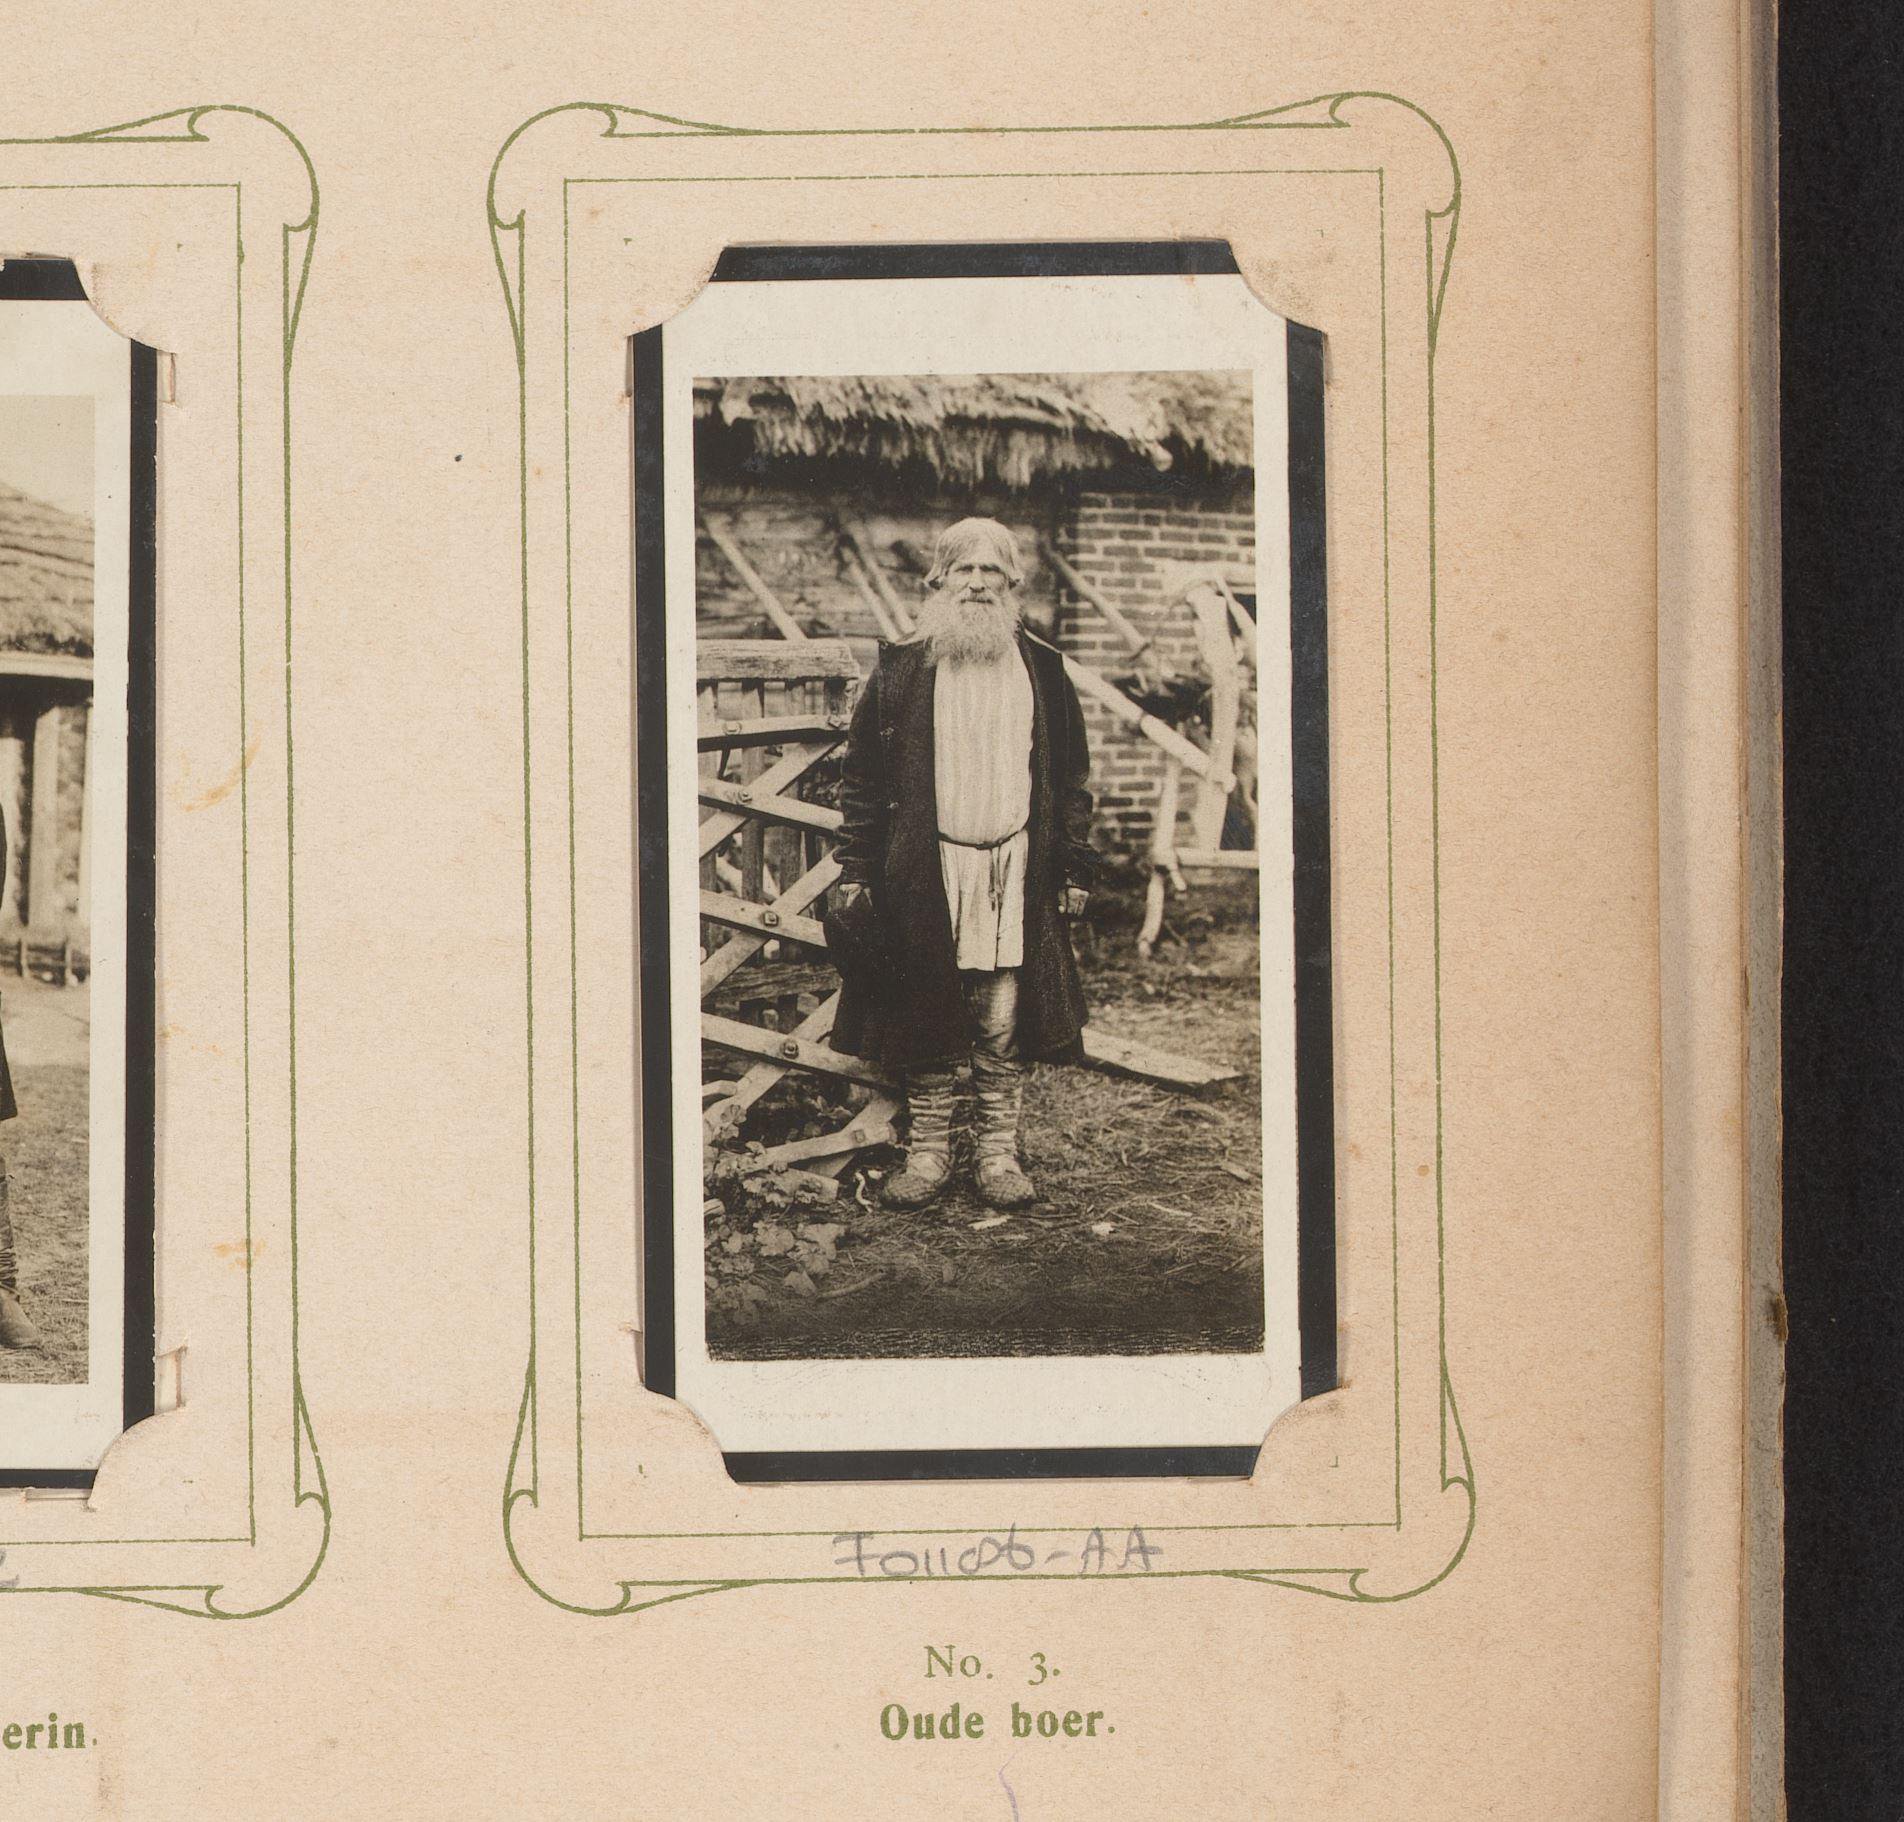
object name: album leaf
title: Portret van een oude Russische boer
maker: Anonymous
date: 1904-1905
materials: photographic support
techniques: gelatin silver print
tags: historical persons, farmers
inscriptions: inscription: ‘No. 3./ Oude boer.’